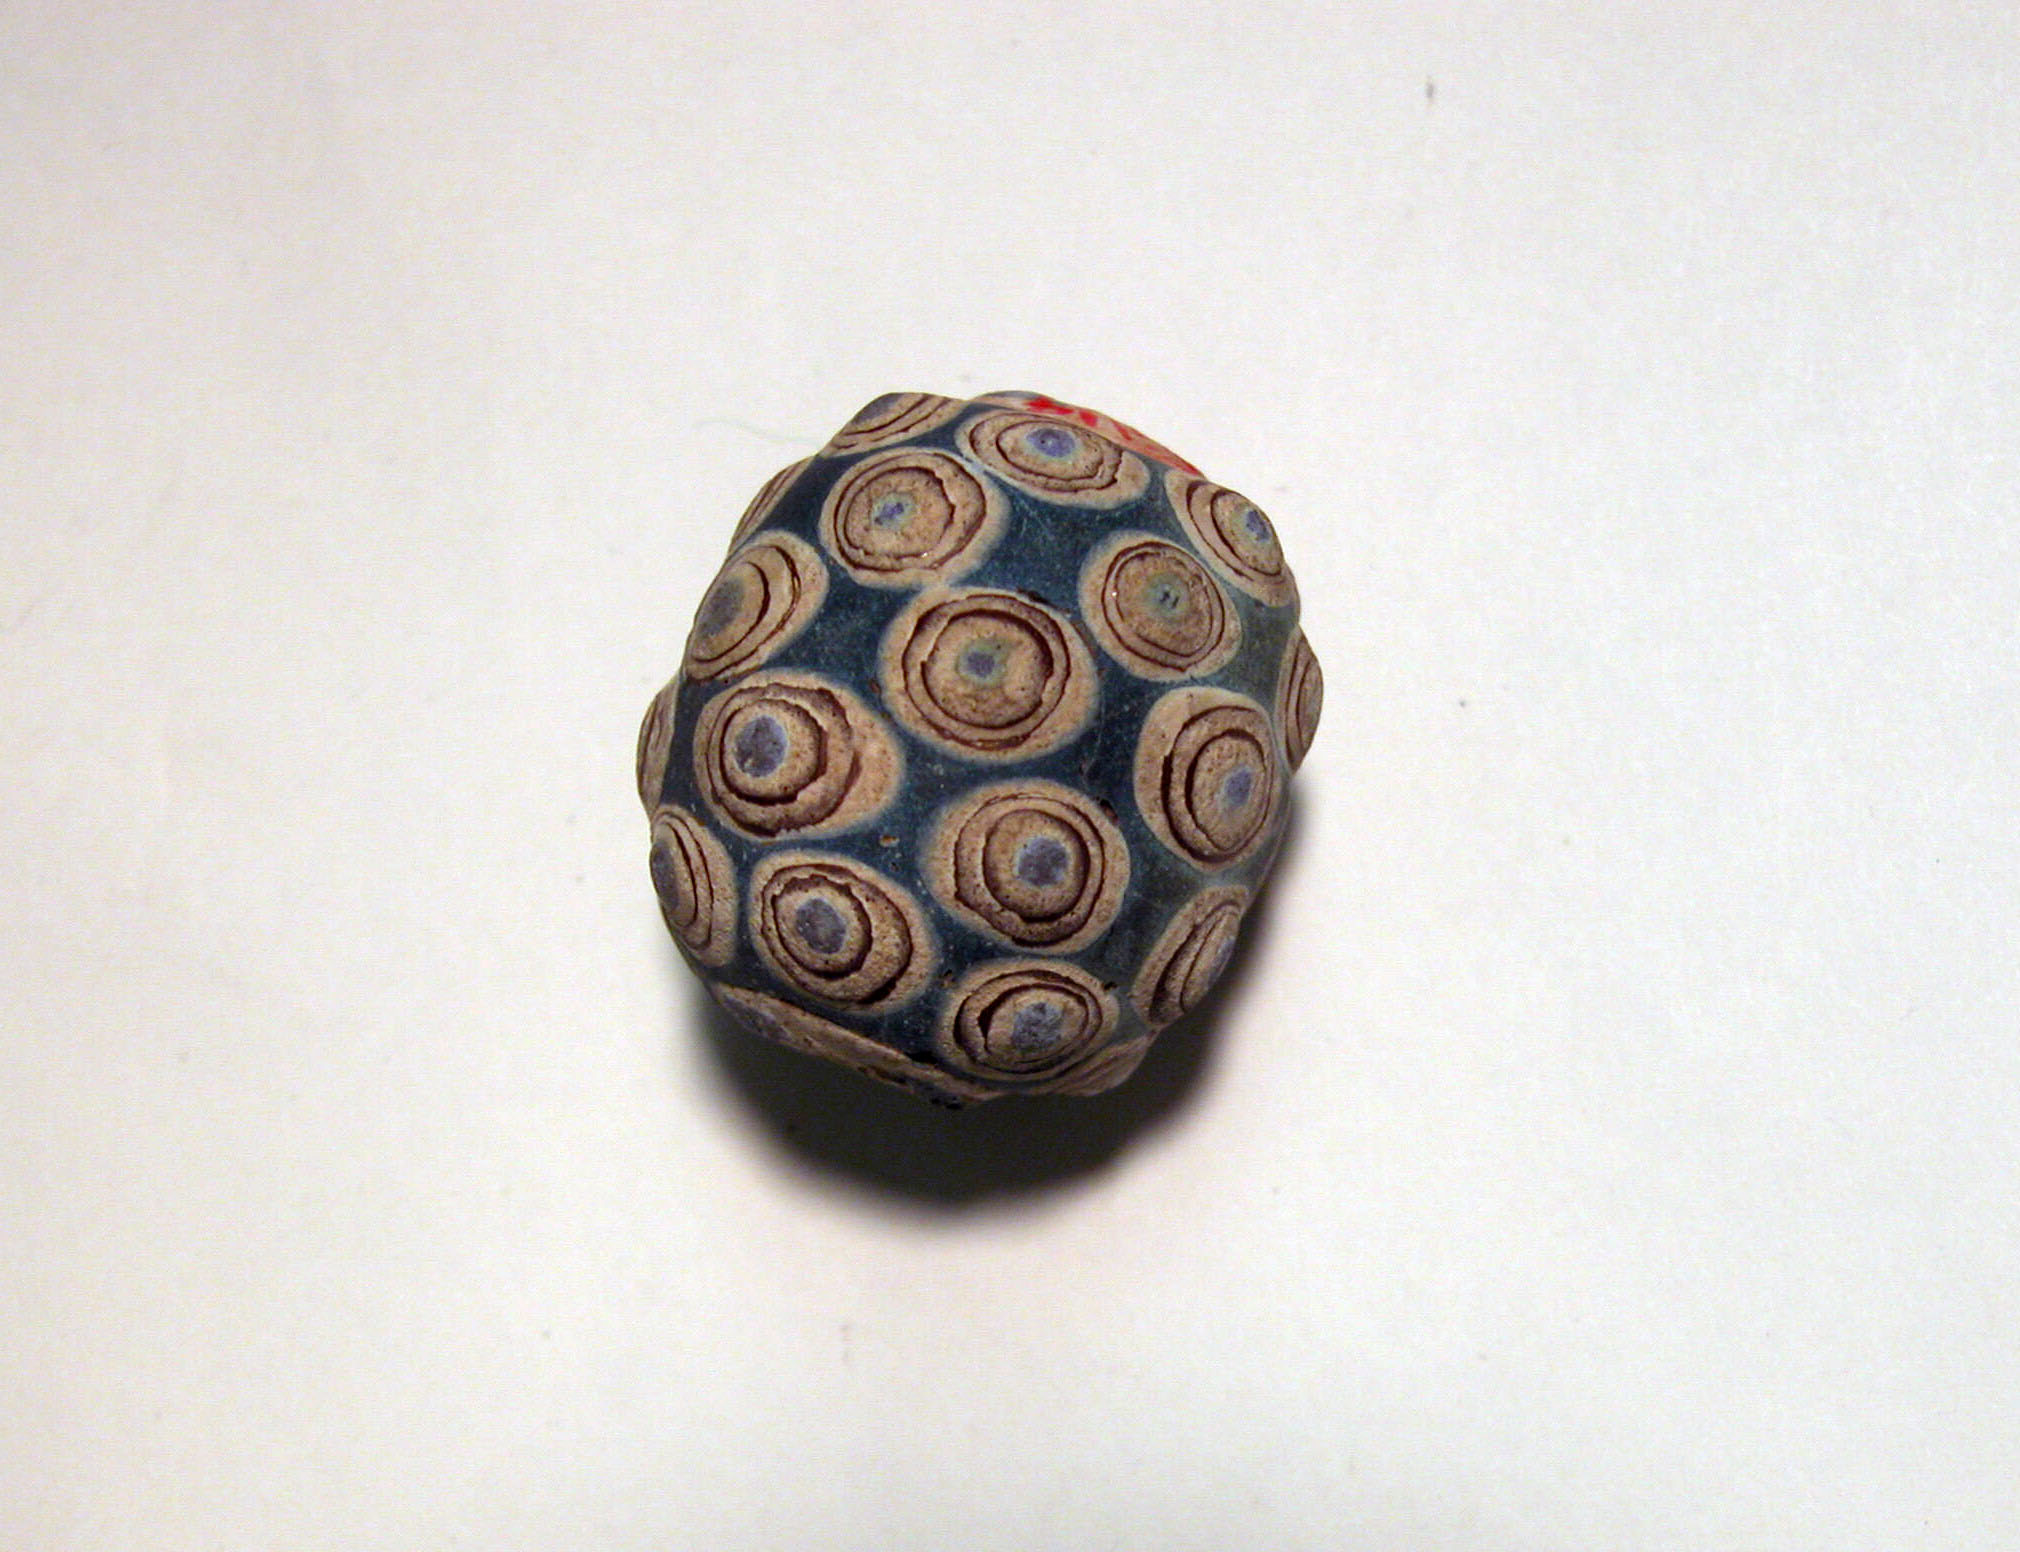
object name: bead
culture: chinese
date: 770-256 BCE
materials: ceramic, glass, paste